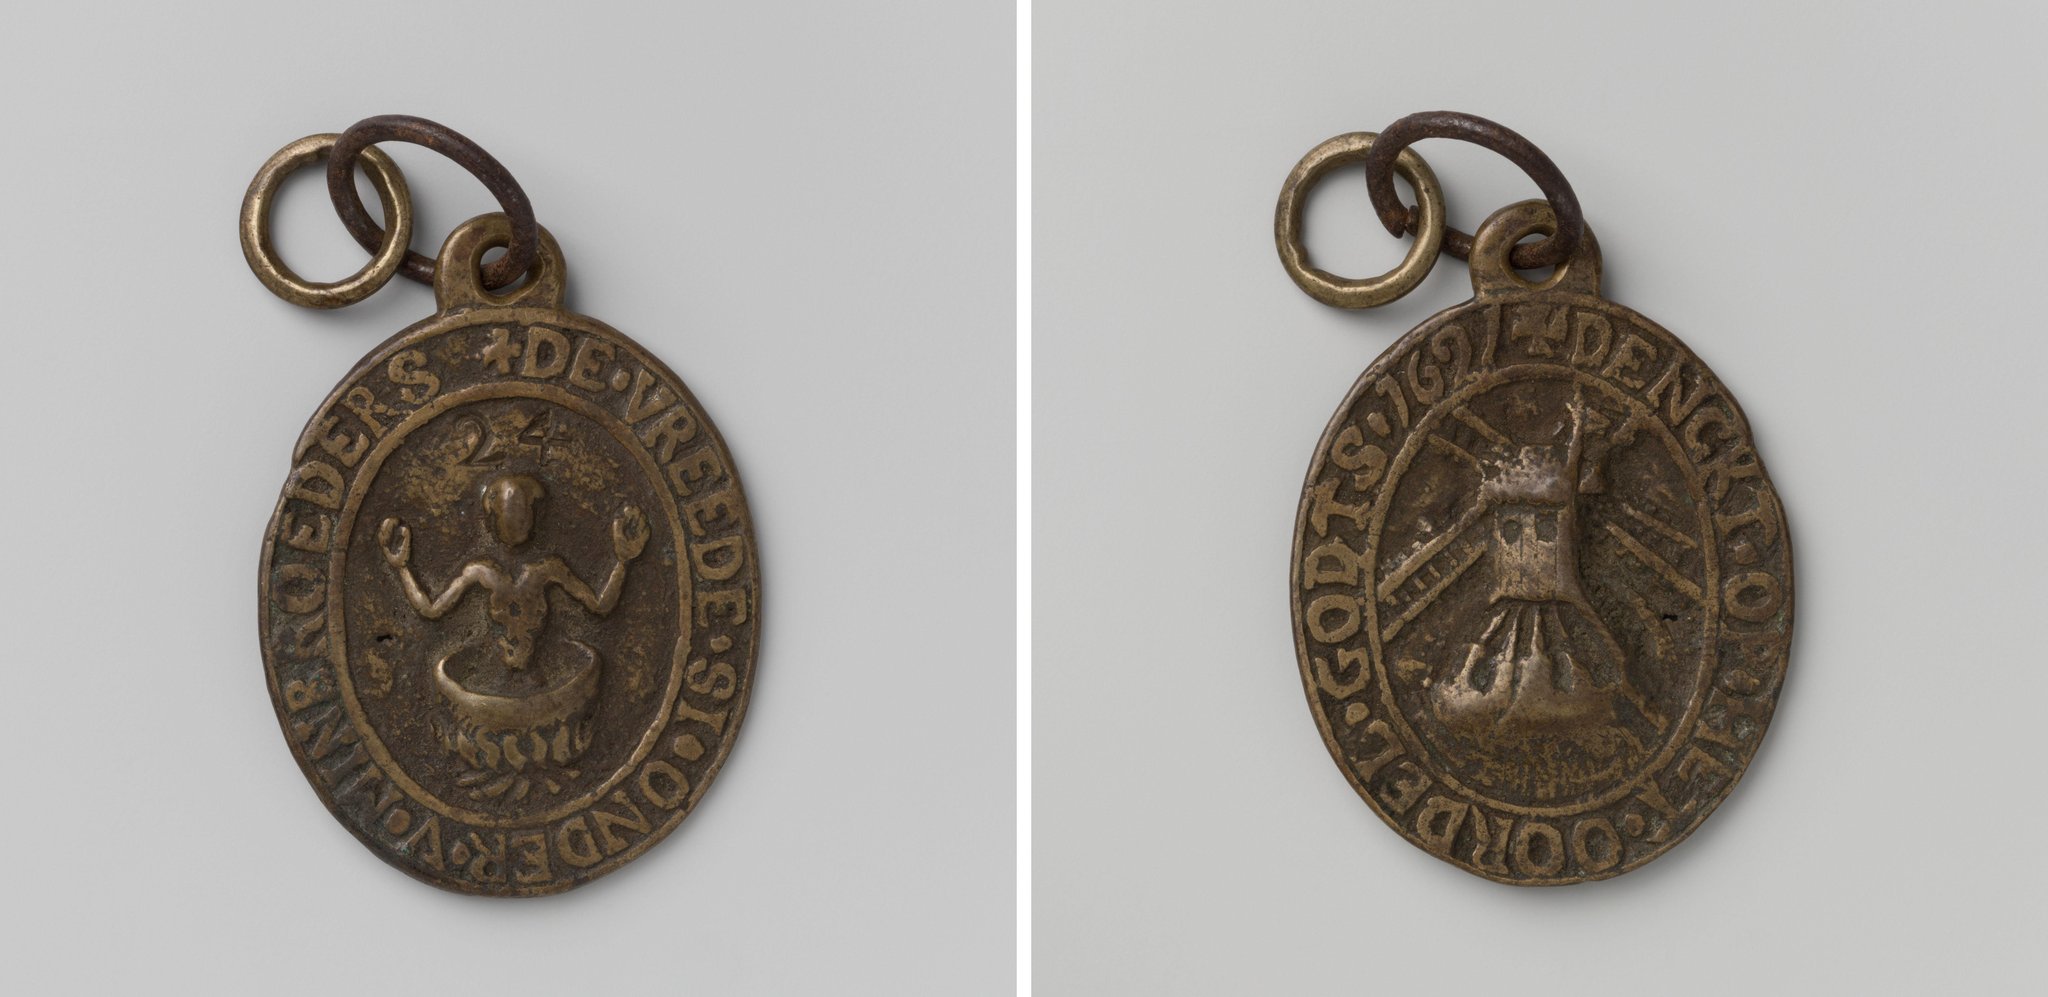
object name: medal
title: Molenaarsgilde van 's-Hertogenbosch, gildepenning met no. 24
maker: Anonymous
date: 1691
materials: brass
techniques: casting, engraving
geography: den bosch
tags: den bosch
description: Ovale messing penning aan twee draagringen en draagoog. Voorzijde: Christus met geheven handen, staande in doopvont; daarboven: cijfer 24 binnen omschrift. Keerzijde: standaardmolen binnen omschrift.